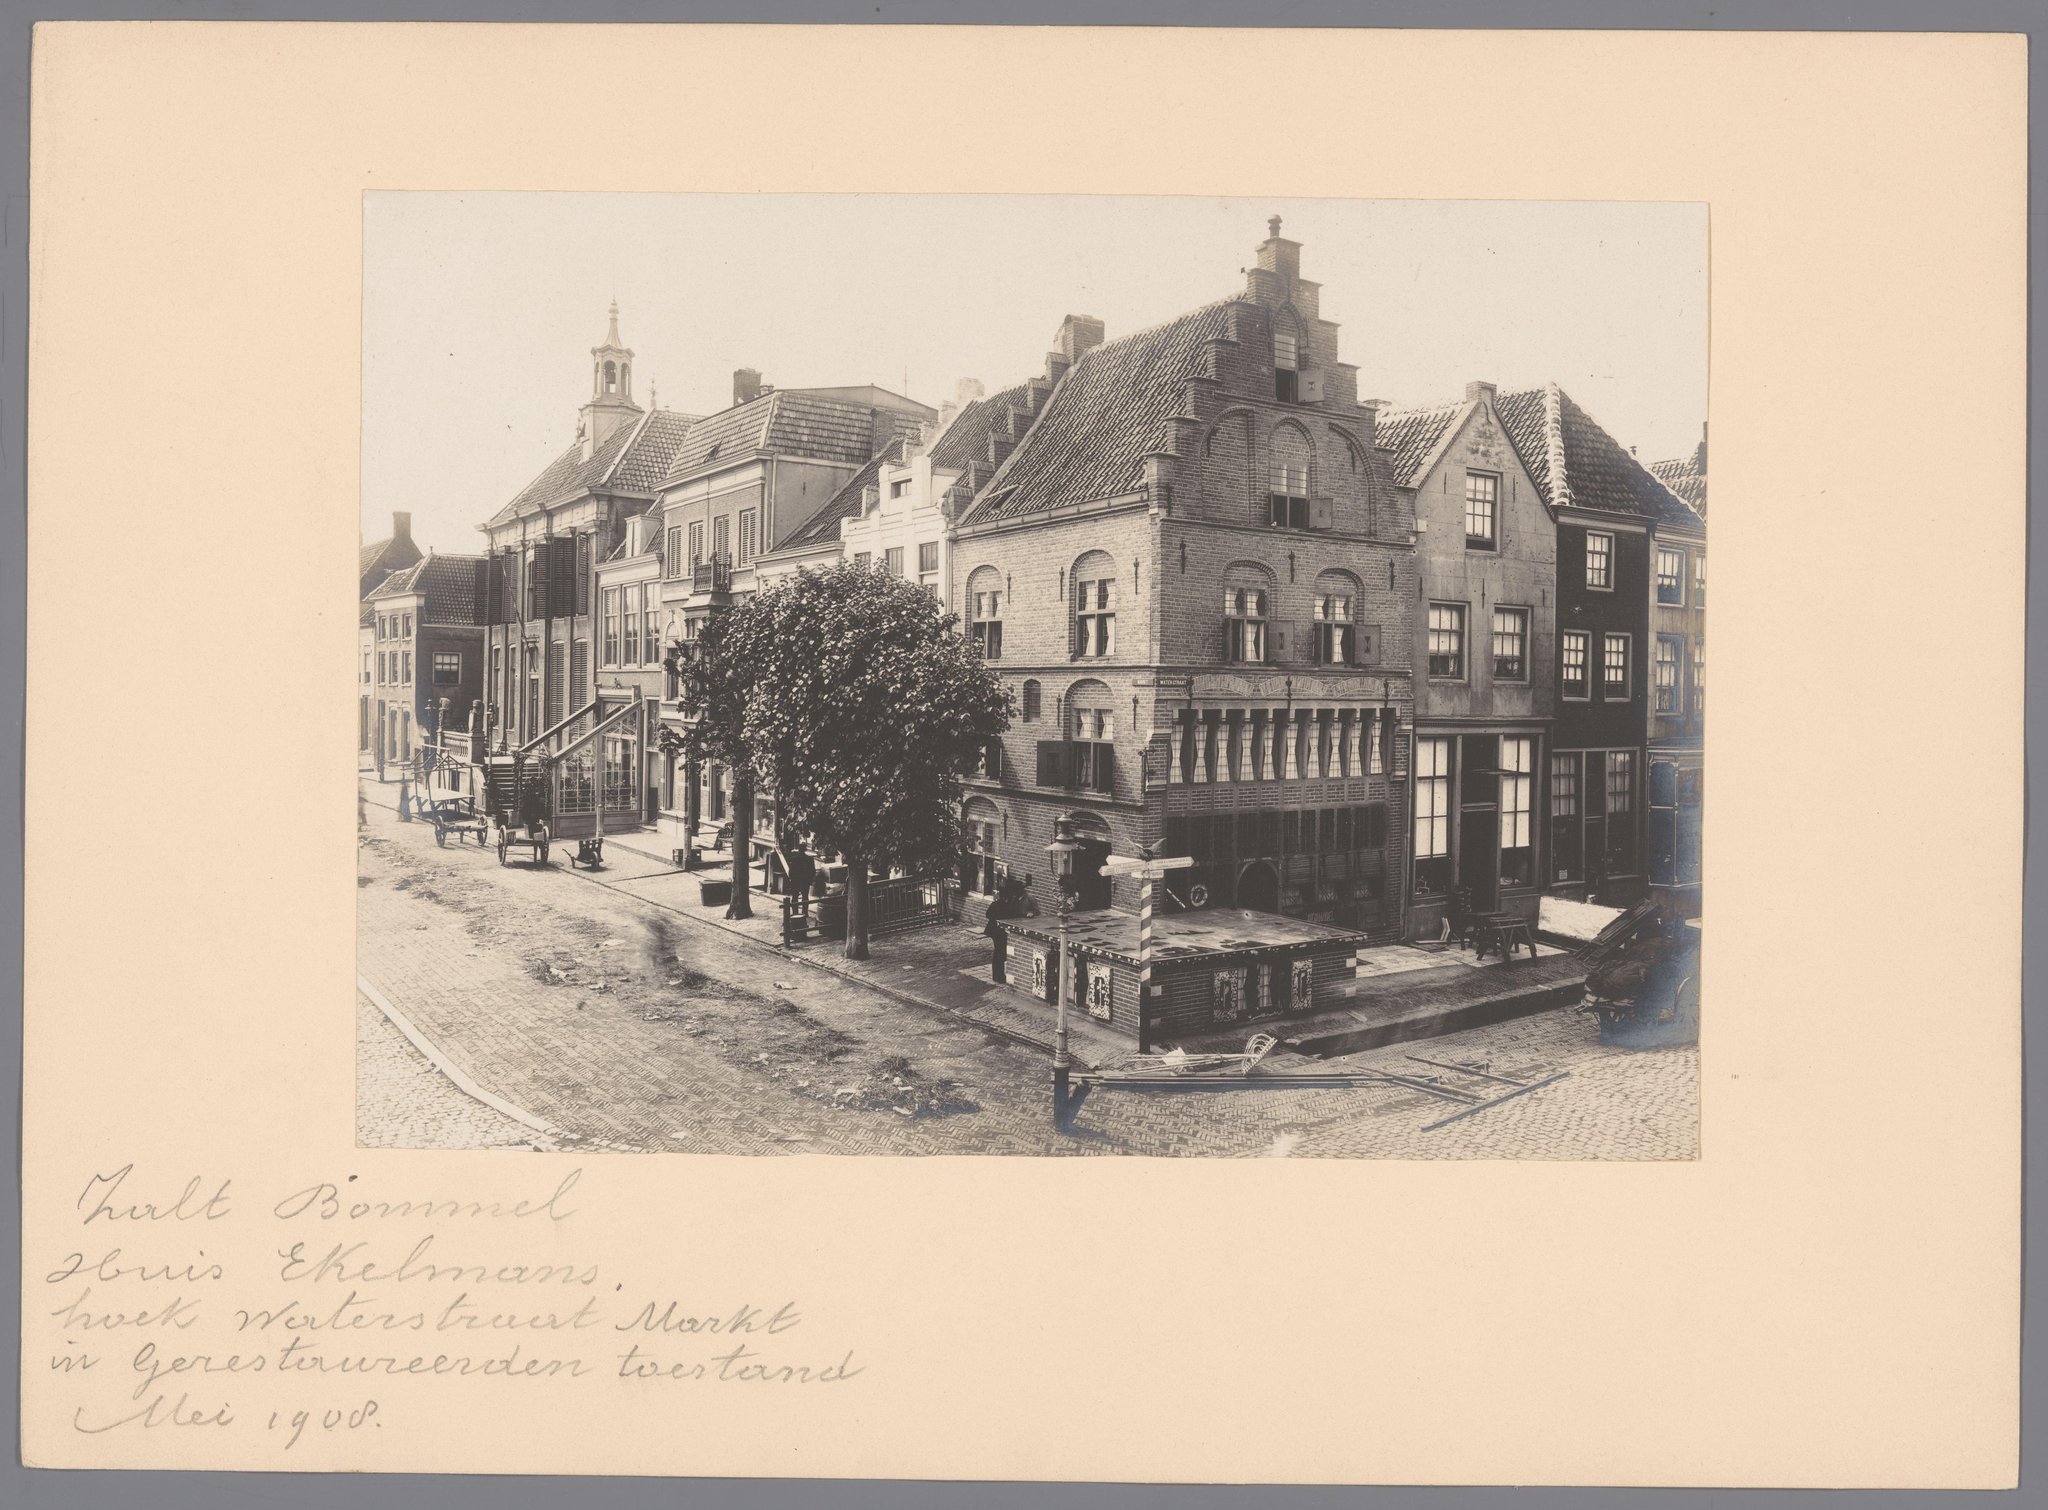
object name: photograph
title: Gezicht op huis Ekelmans te Zaltbommel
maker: anoniem (monumentenzorg)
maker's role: fotograaf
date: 1890-1920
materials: cardboard, photographic support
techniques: gelatin silver print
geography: zaltbommel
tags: urban housing, street (+ city(-scape) with figures, staffage)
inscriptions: annotation: ‘Zalt Bommel/ Huis Ekelmans/ hoek Waterstraat Markt/ in gerestaureerden toestand/ Mei 1908’